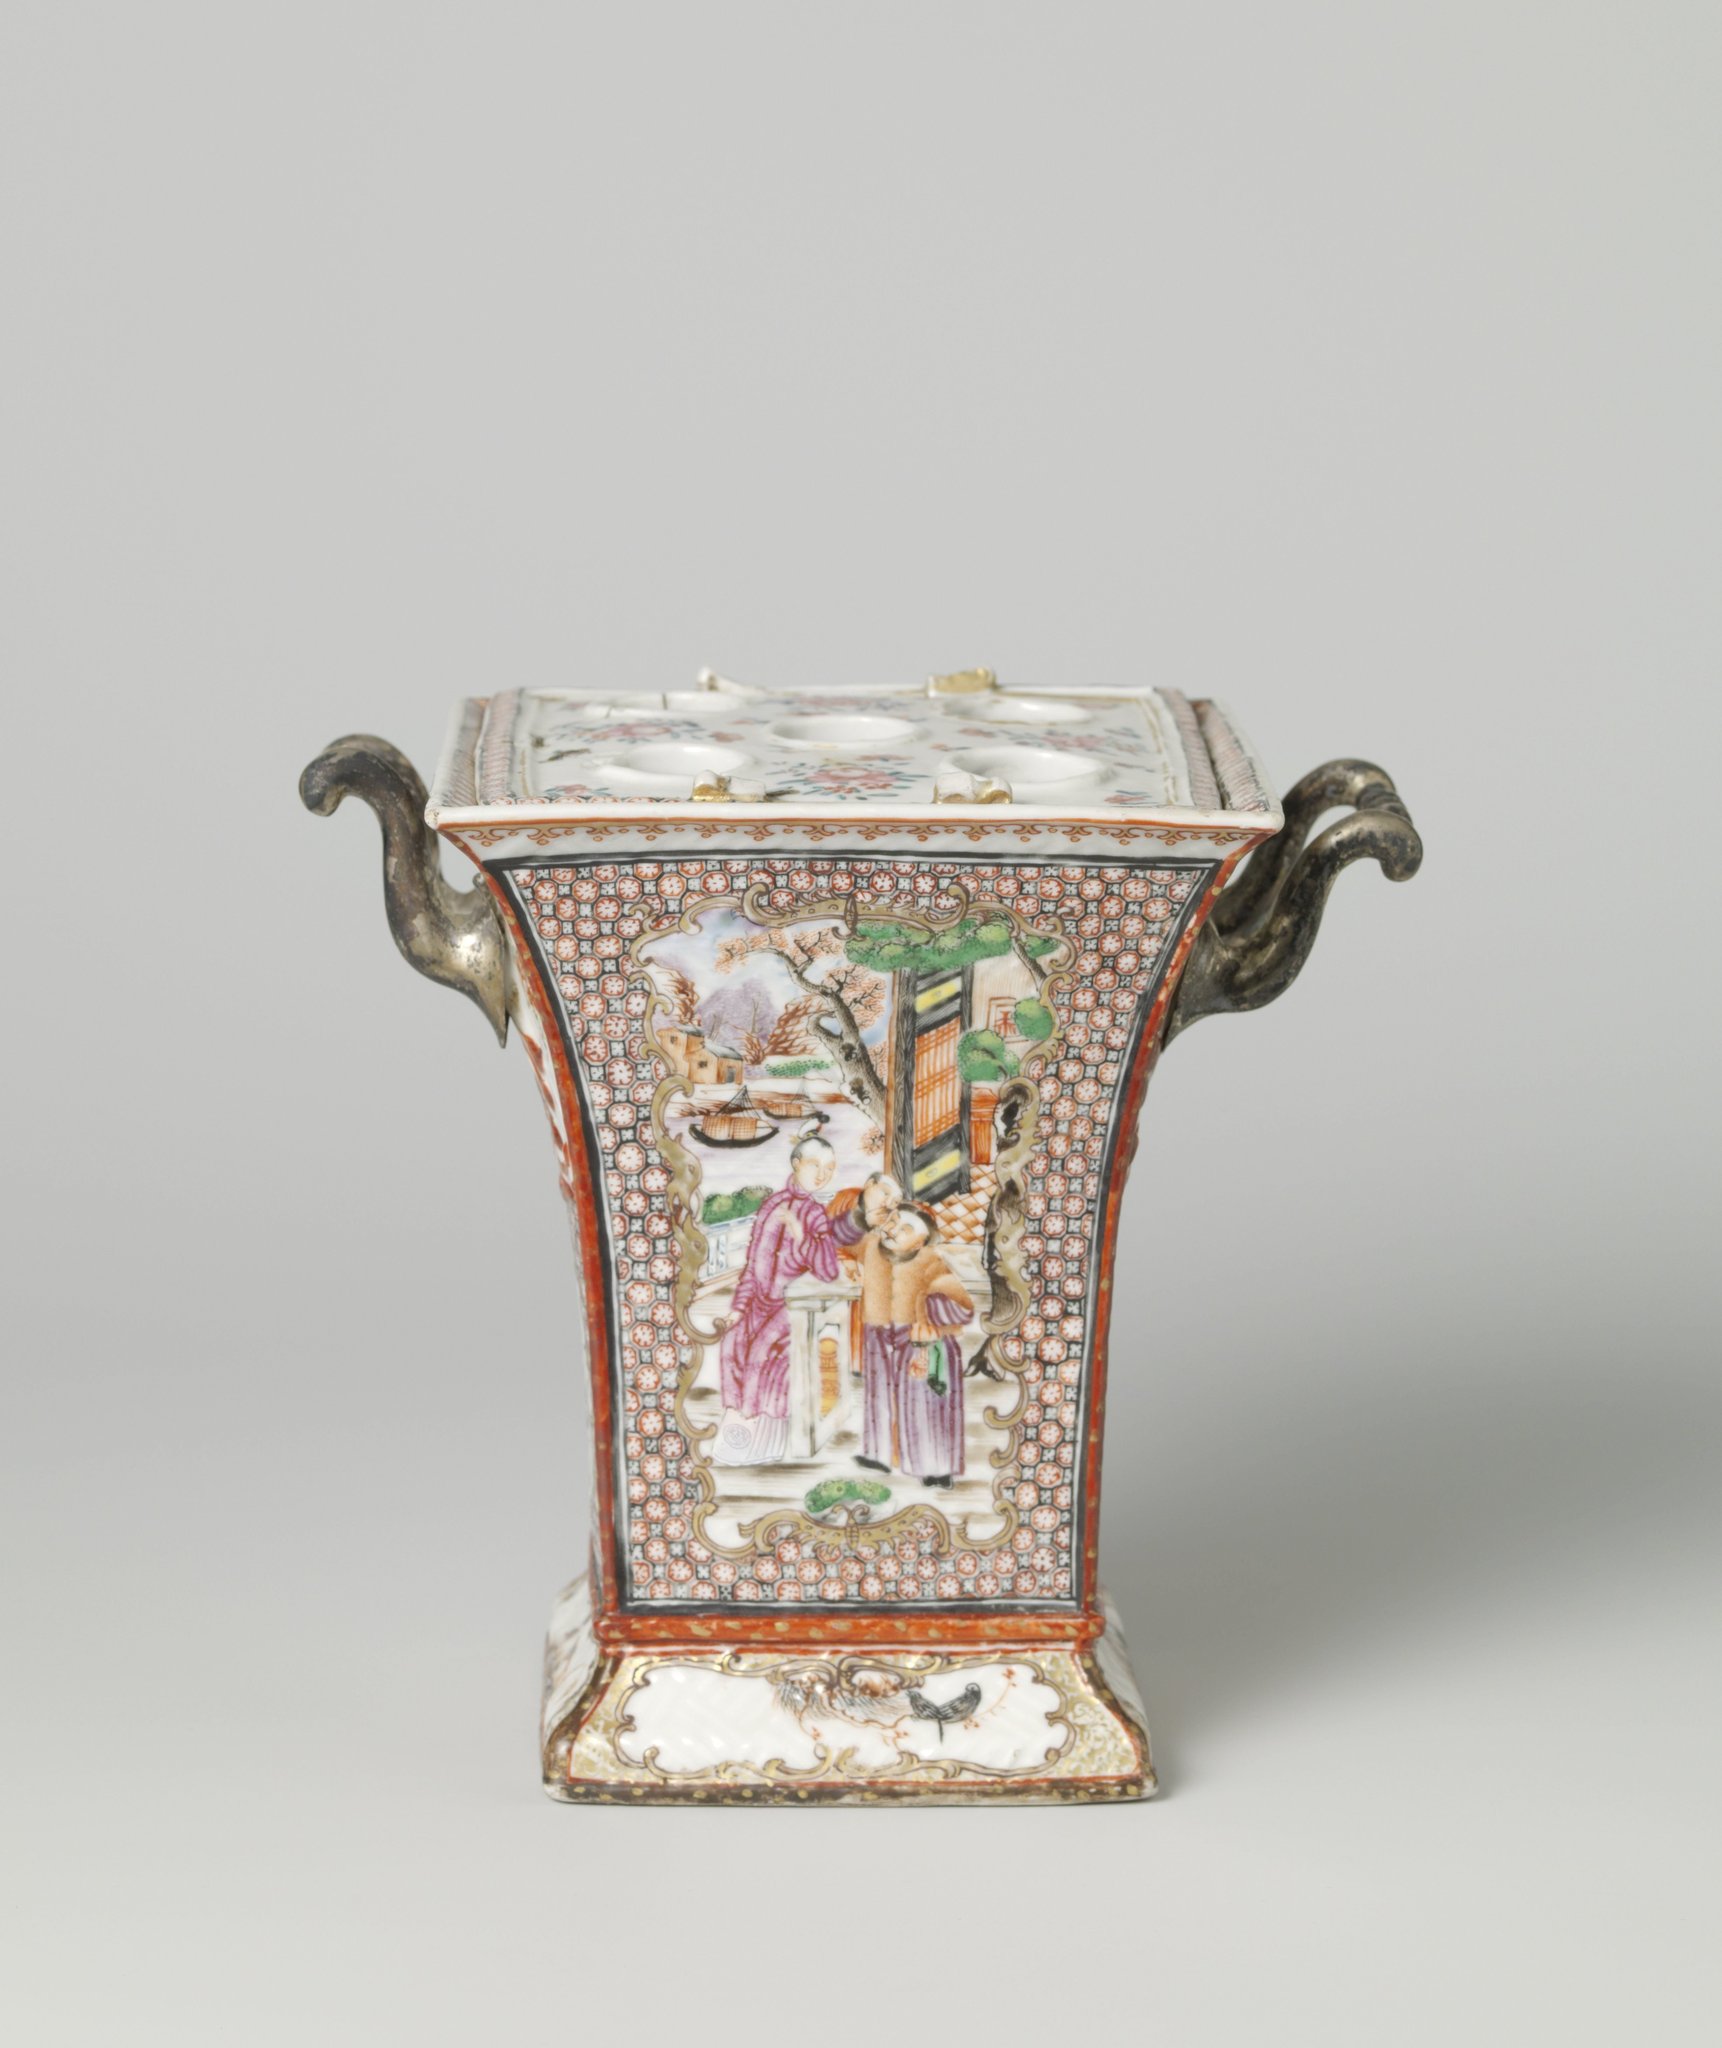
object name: lid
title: Square bough pot with figures on a terrace, birds and flower sprays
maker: Anonymous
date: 1770-1790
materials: glaze, gold, paint, porcelain, silver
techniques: firing, forming, gilding, vitrification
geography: china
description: Deksel van vierkante bloempot of vaas van porselein, beschilderd op het glazuur in blauw, rood, roze, groen, geel, paars, zwart en goud. Deksel is gebroken geweest en op vier plekken gerestaureerd met ijzerdraad. Europese vormen met famille rose/mandarijn.